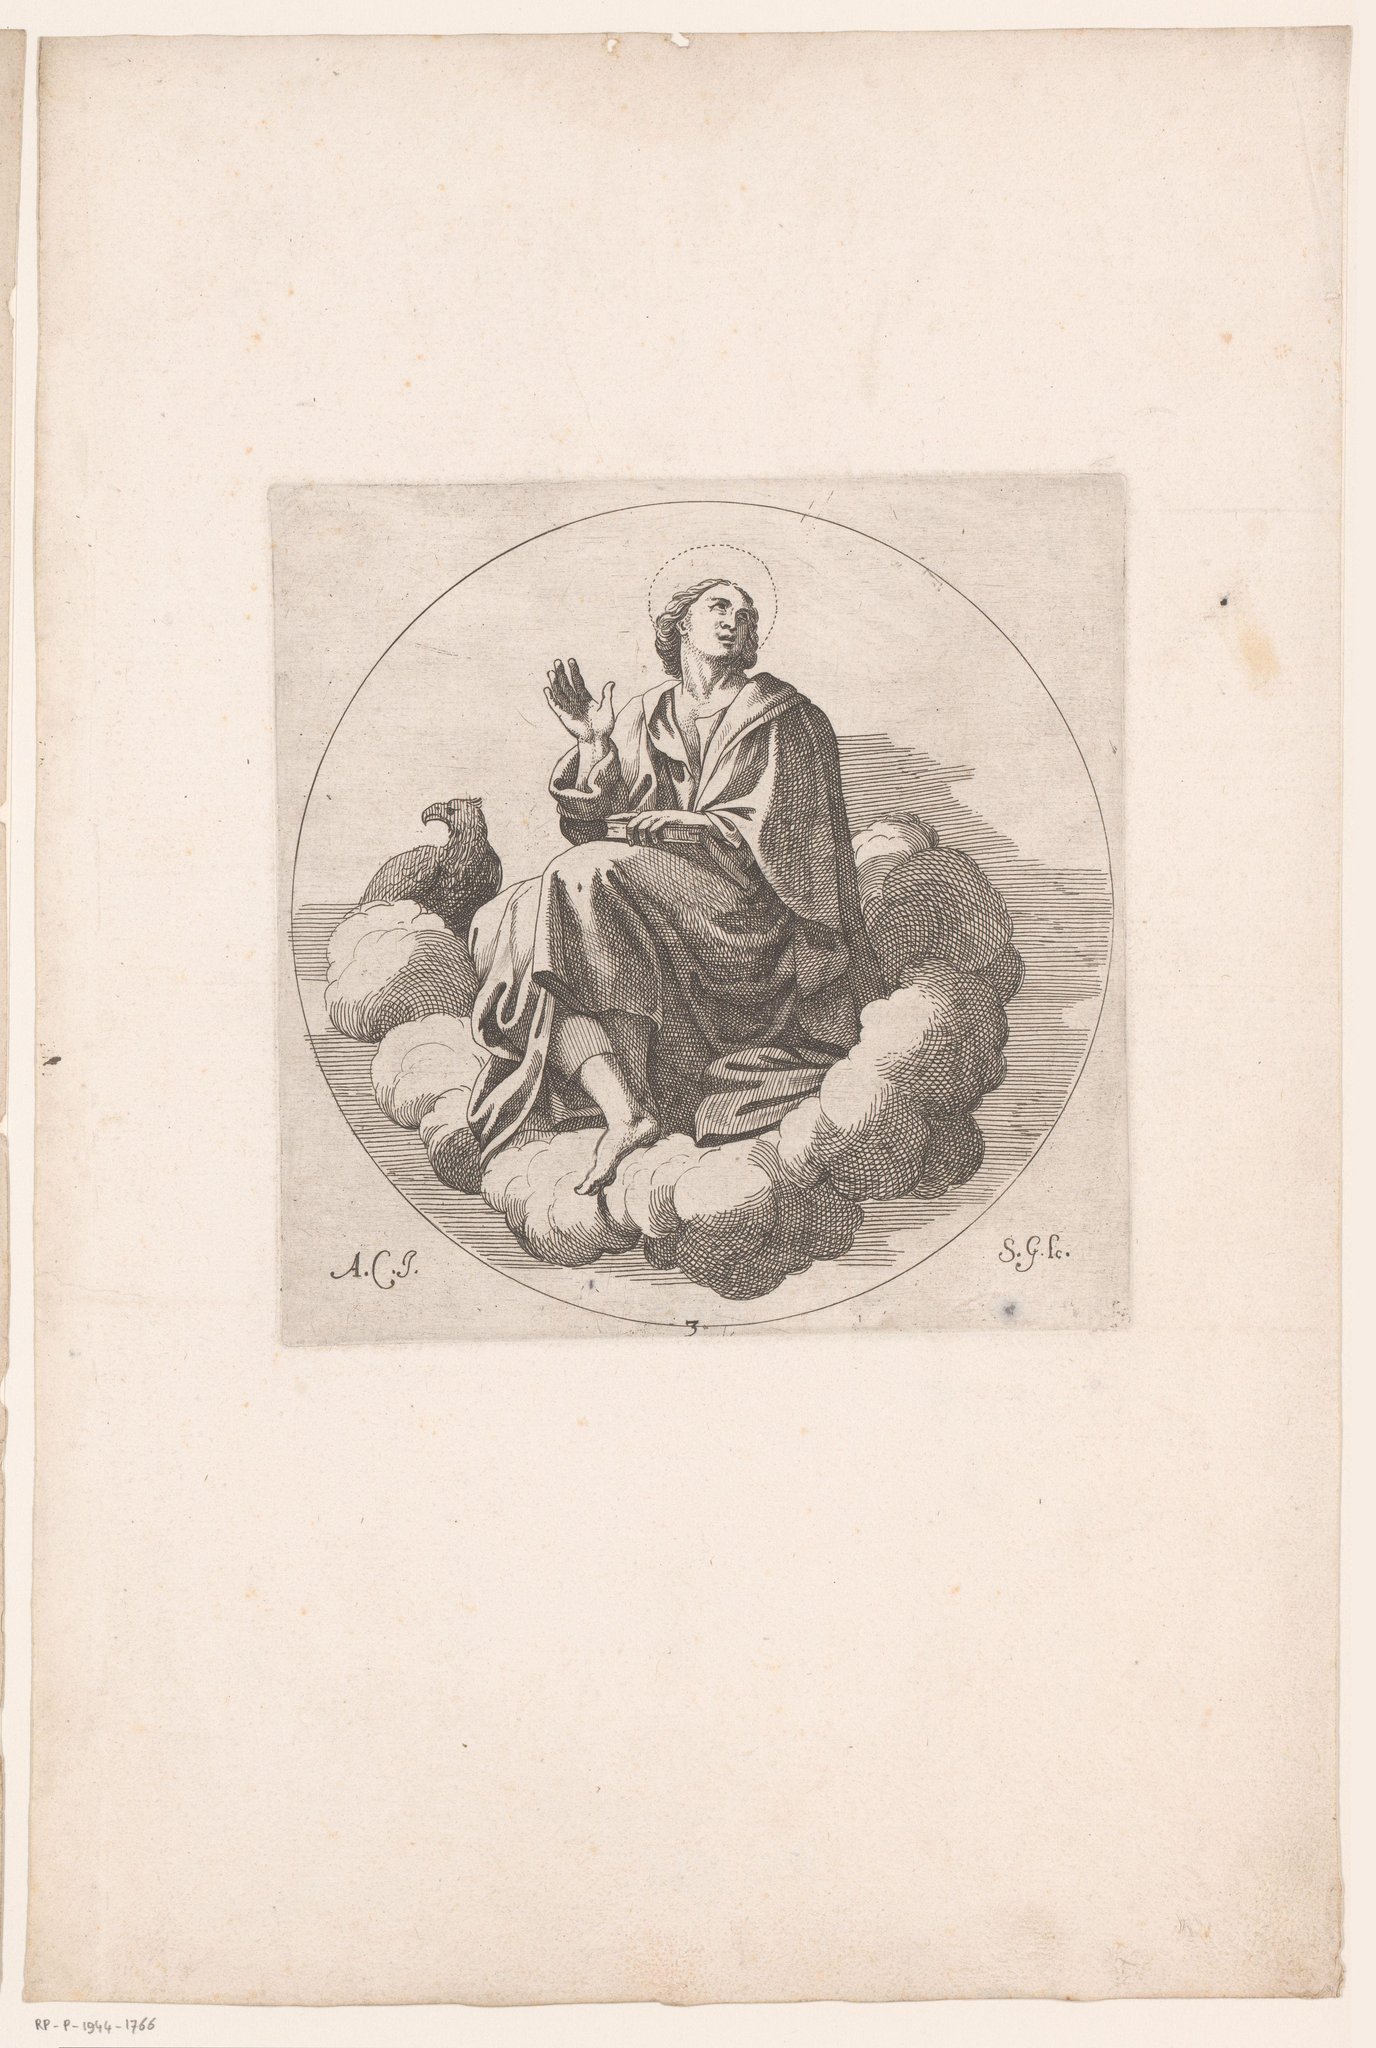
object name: print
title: Vita di San Diego dipinta nella Capella di S. Giacomo de Spagnoli a Roma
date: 1646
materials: paper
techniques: etching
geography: rome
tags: the apostle john the evangelist; possible attributes: book, cauldron, chalice with snake, eagle, palm, scroll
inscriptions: collector's mark: Lugt 2228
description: Maakt deel uit van een twintigdelige serie getiteld 'Vita di San Diego dipinta nella Capella di S. Giacomo de Spagnoli a Roma' met scènes uit het leven van Juan Diego Cuauhtlatoatzin door Annibale Carracci in Herrera kapel van de Nostra Signora del Sacro Cuore te Rome. De serie werd in 1646 uitgegeven in Rome.